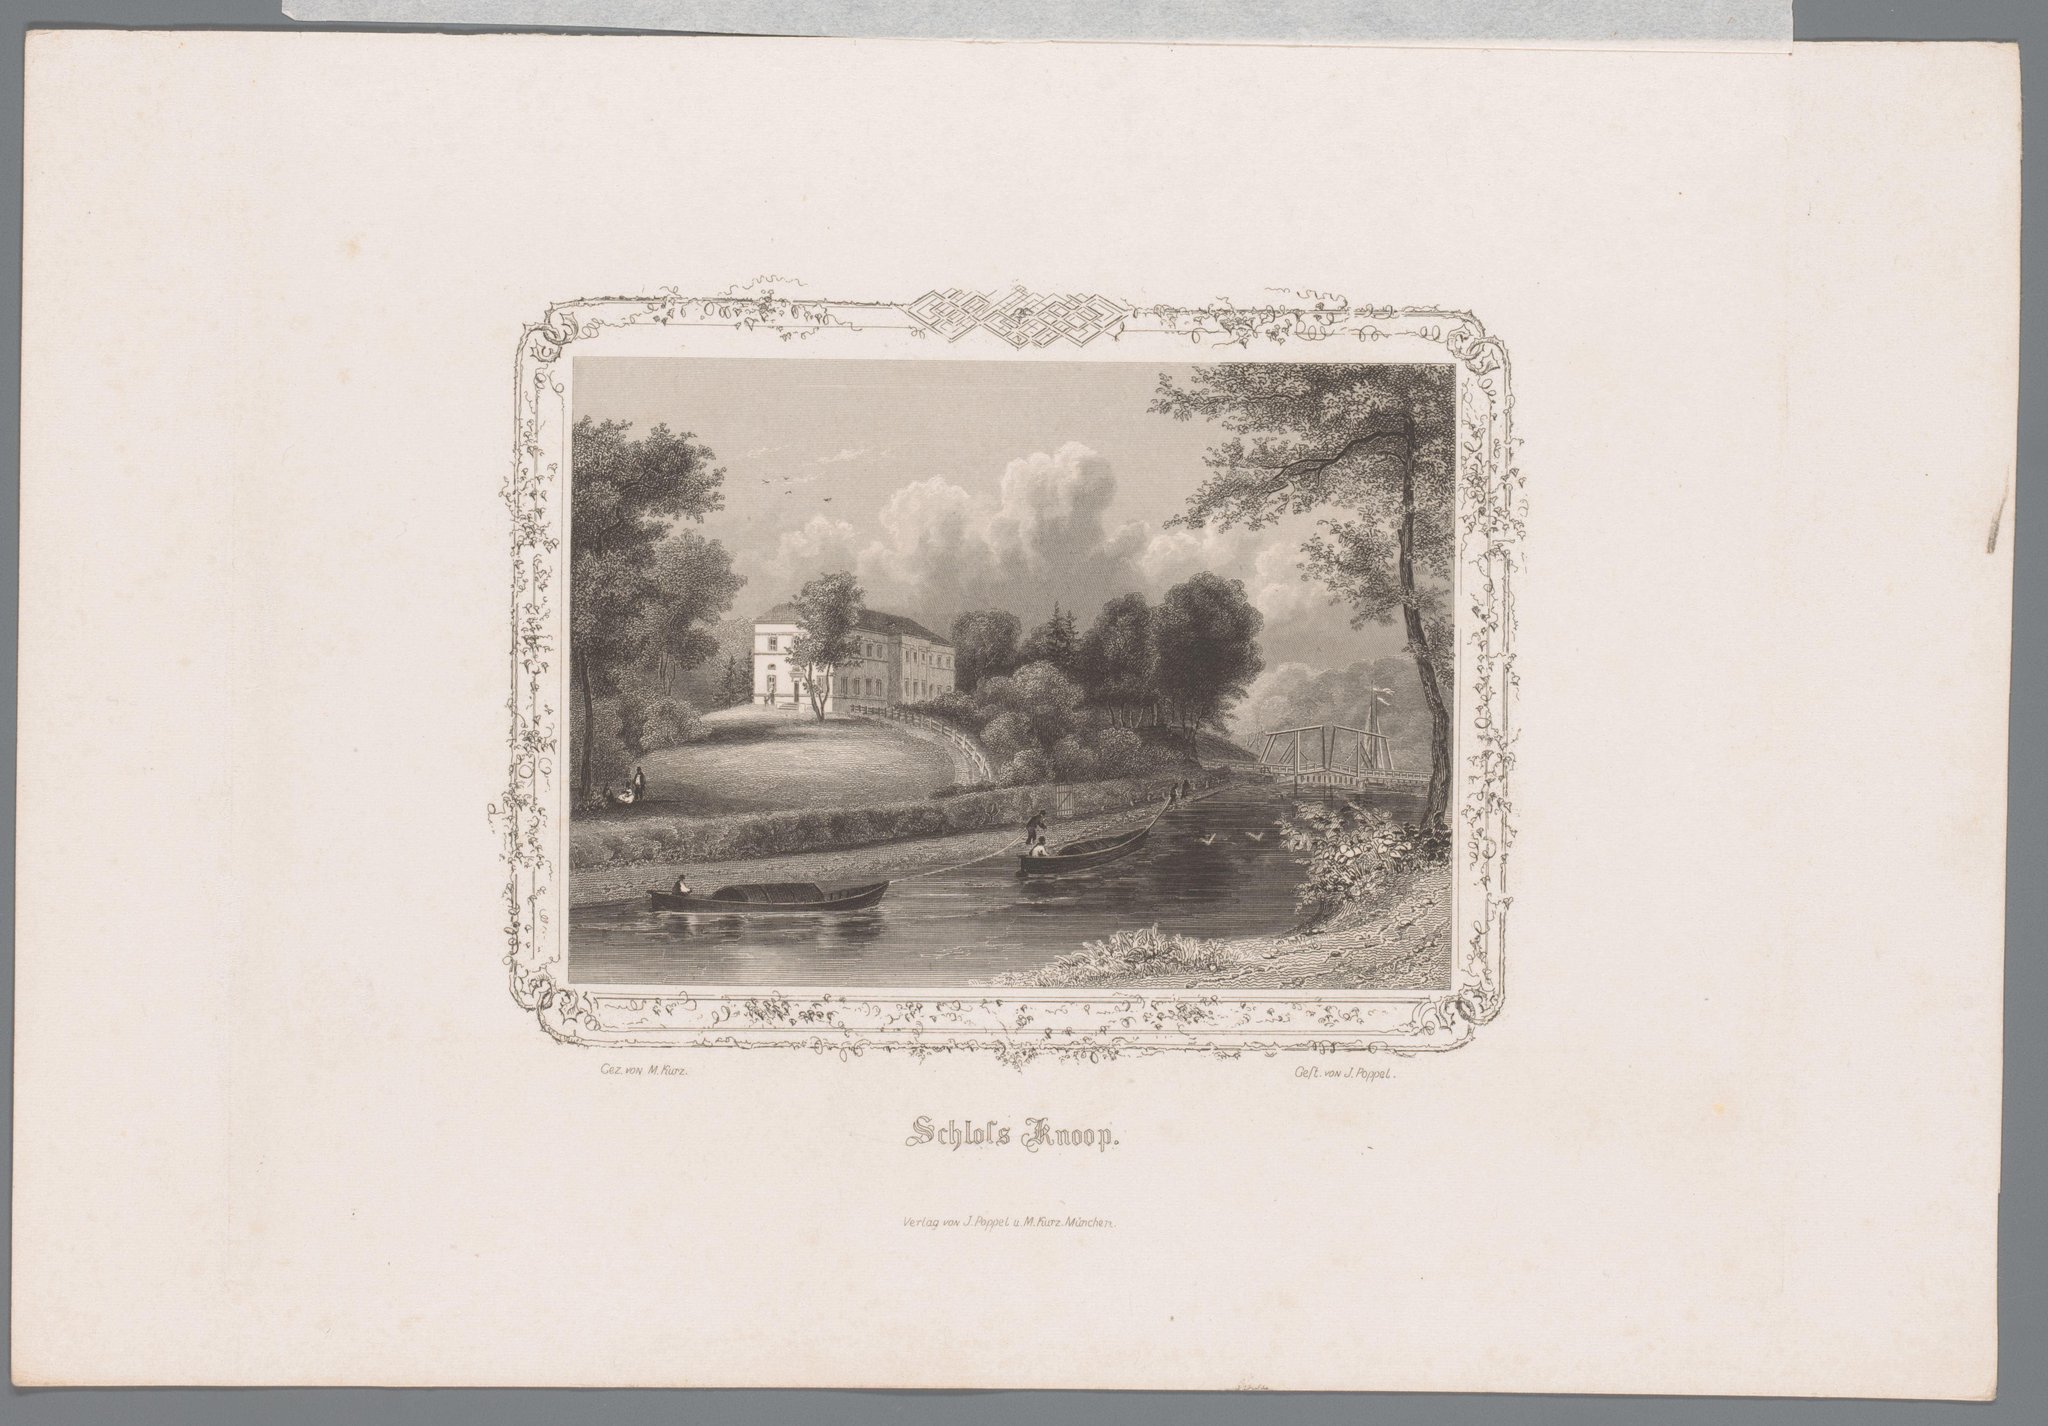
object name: print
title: Landschappen in Sleeswijk-Holstein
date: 1847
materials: paper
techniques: engraving, etching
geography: munich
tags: villa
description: Deze prent behoort tot deel één of twee van de serie 'Landschappen in Sleeswijk-Holstein'. Het betreft een vierdelige reeks uitgegeven in twee omslagen waarvan deze omslag deel één en twee bevat met daarin zes landschappen en zes tekstbladen.